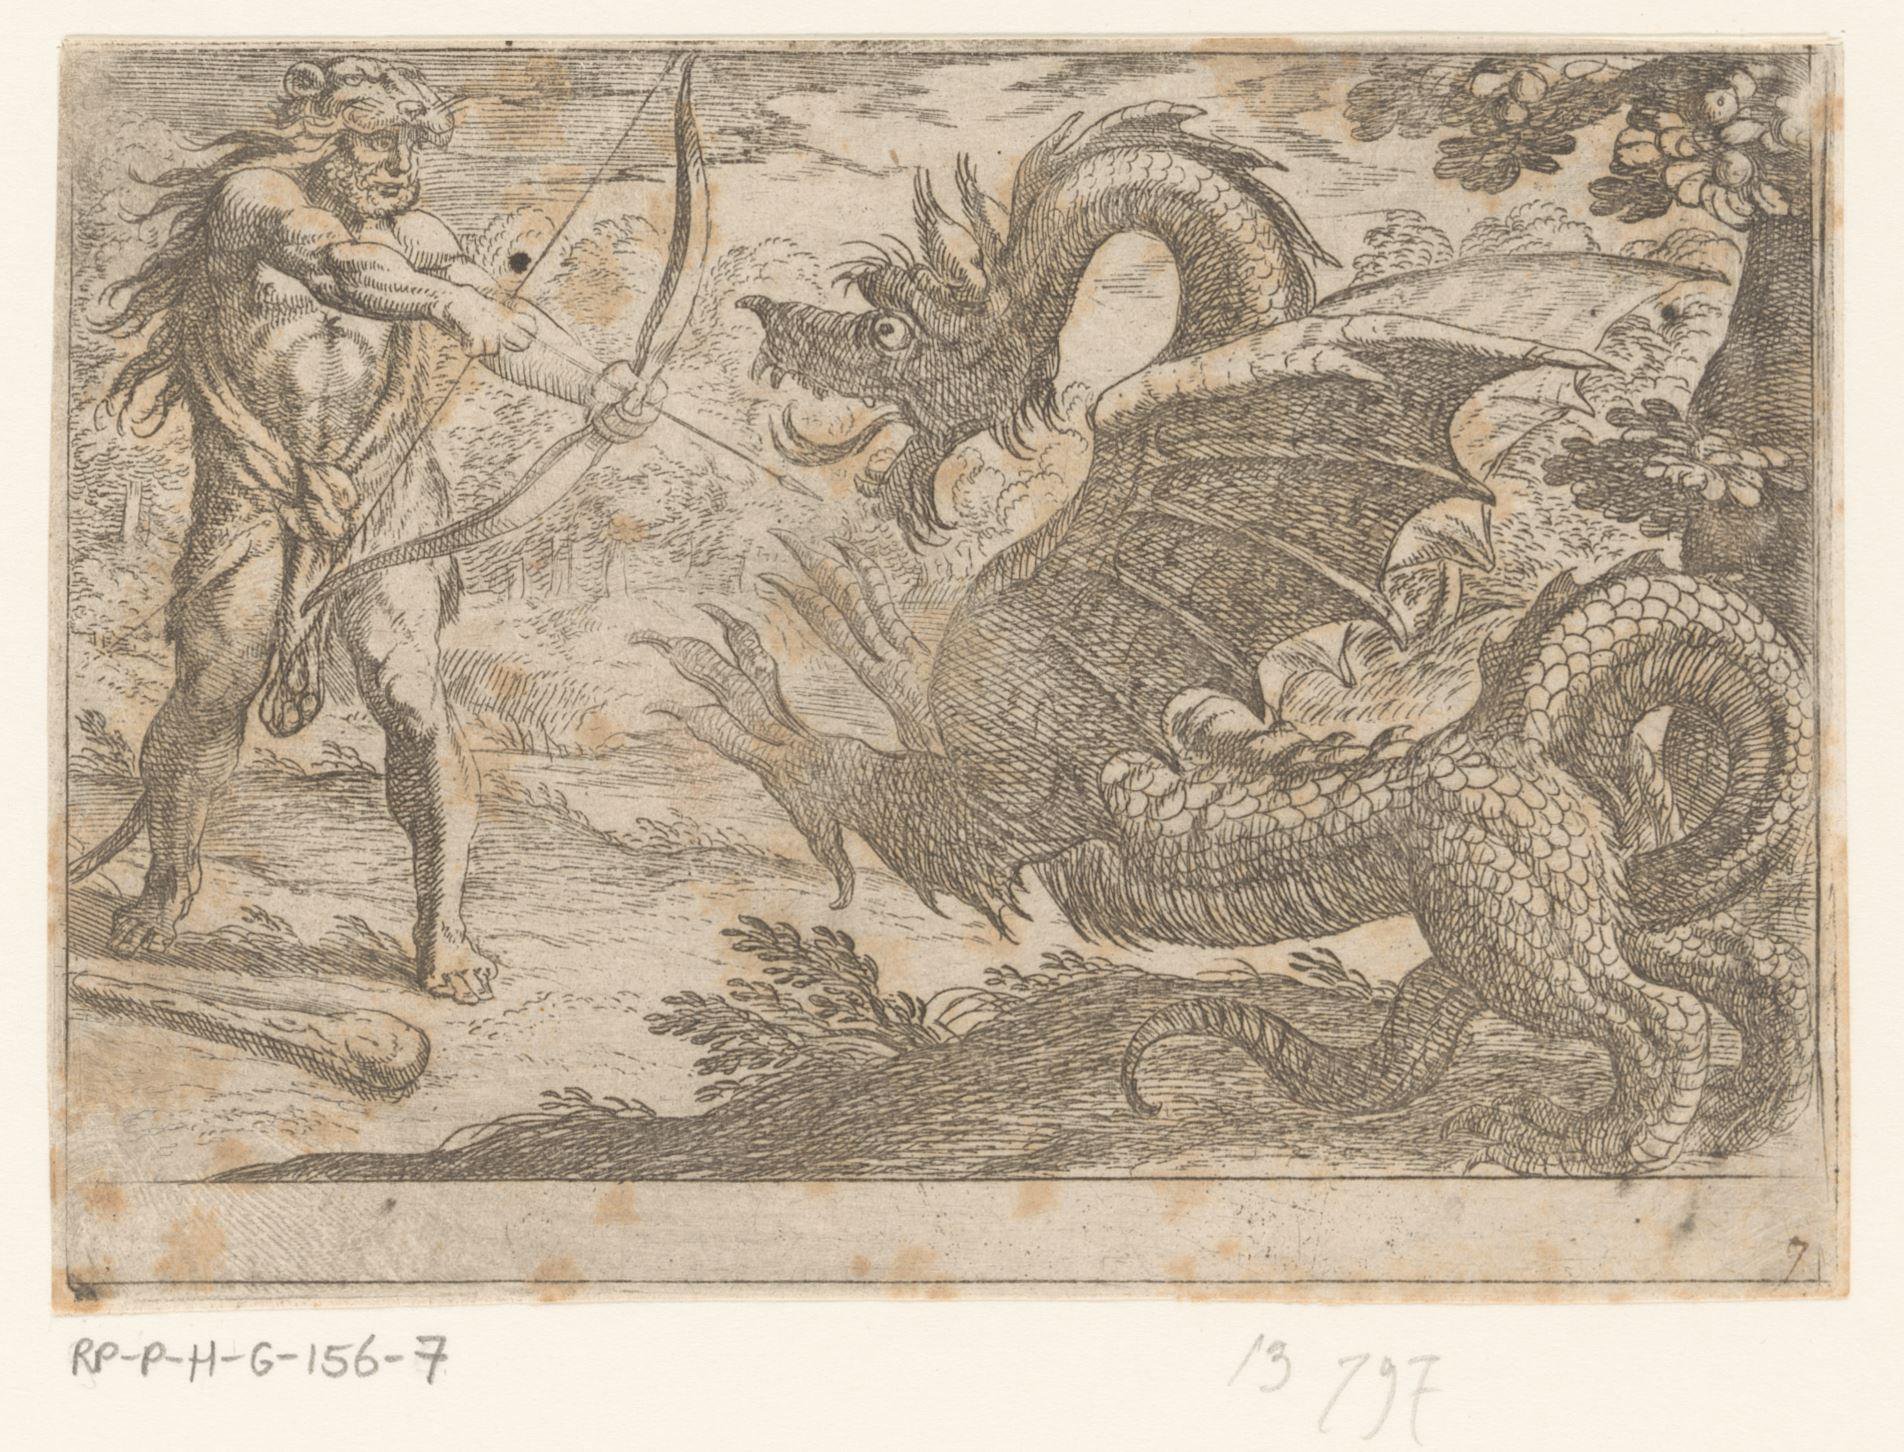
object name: print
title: Hercules en de draak Ladon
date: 1608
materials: paper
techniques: etching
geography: rome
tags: hercules kills ladon, the dragon which kept the tree of the hesperides, most important deeds of hercules: the twelve labours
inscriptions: collector's mark: ‘Hinloopen’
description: Deze prent maakt deel uit van een reeks van 12 prenten van de twaalf werken van Hercules (+ titelprent).